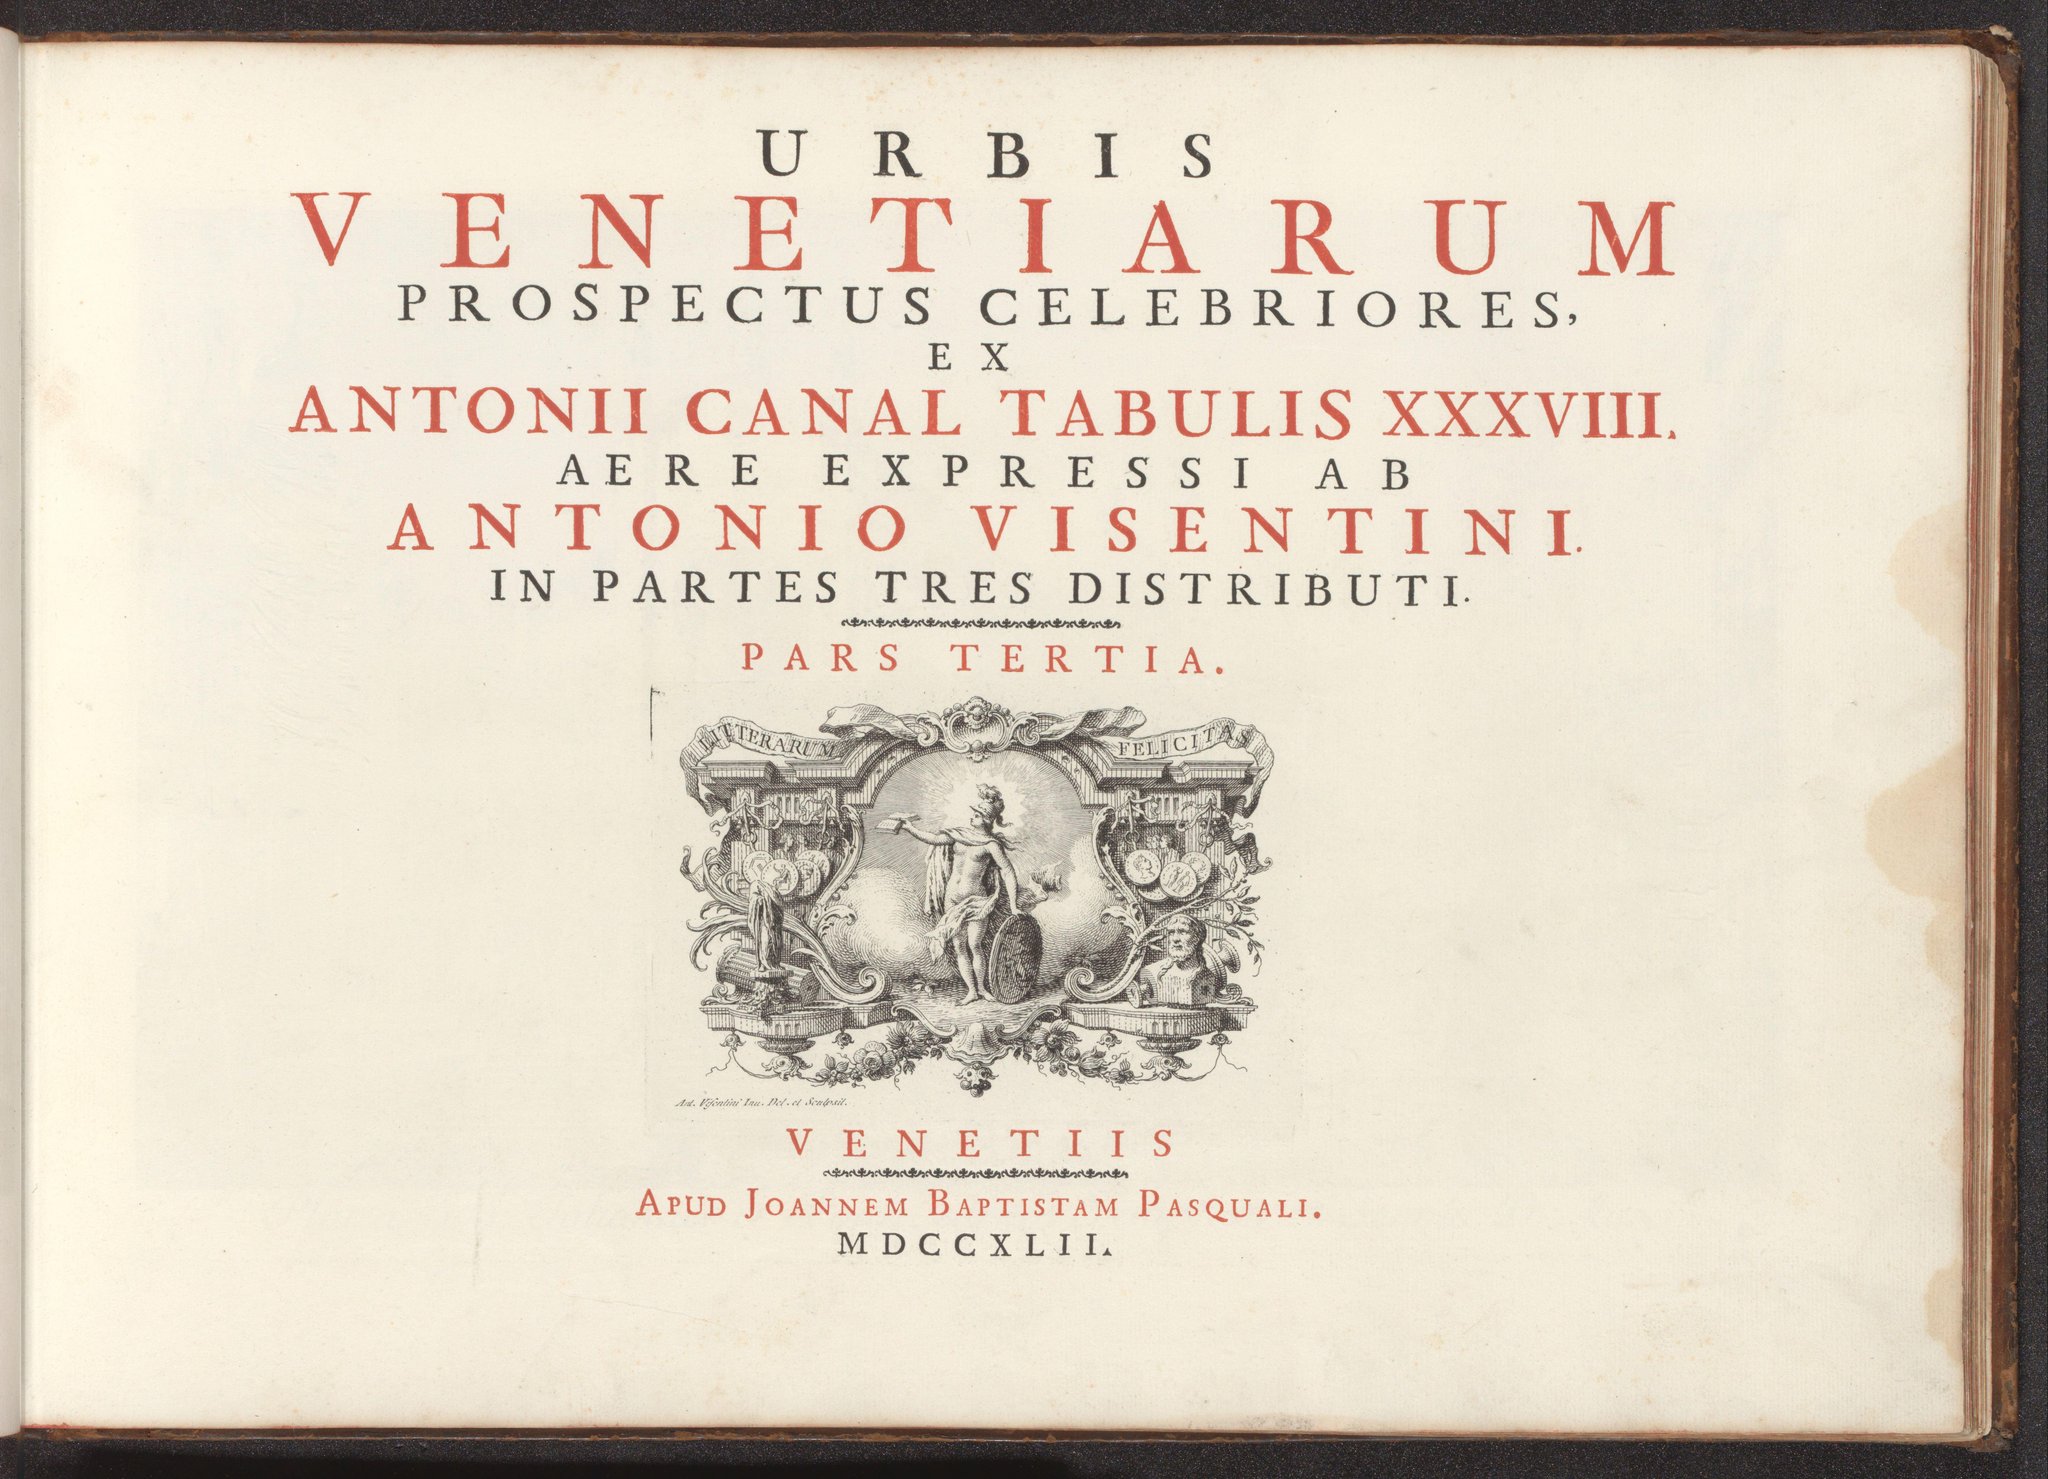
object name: titelprent, frontispice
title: Urbis Venetiarum prospectus celebriores, ex Antonii Canal tabulis XXXVIII aere expressi ab Antonio Vissentini in partes tres distributi. pars tertia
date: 1742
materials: paper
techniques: etching, letterpress printing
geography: venice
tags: abstract ideas and concepts (+ abstract concept represented by female figure), ornament ~ cartouche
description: Een cartouche met een naakte vrouwenfiguur met schild, helm en boek. Boven een banderol met de tekst: Literarum Felicitas. De prent maakt deel uit van een album.